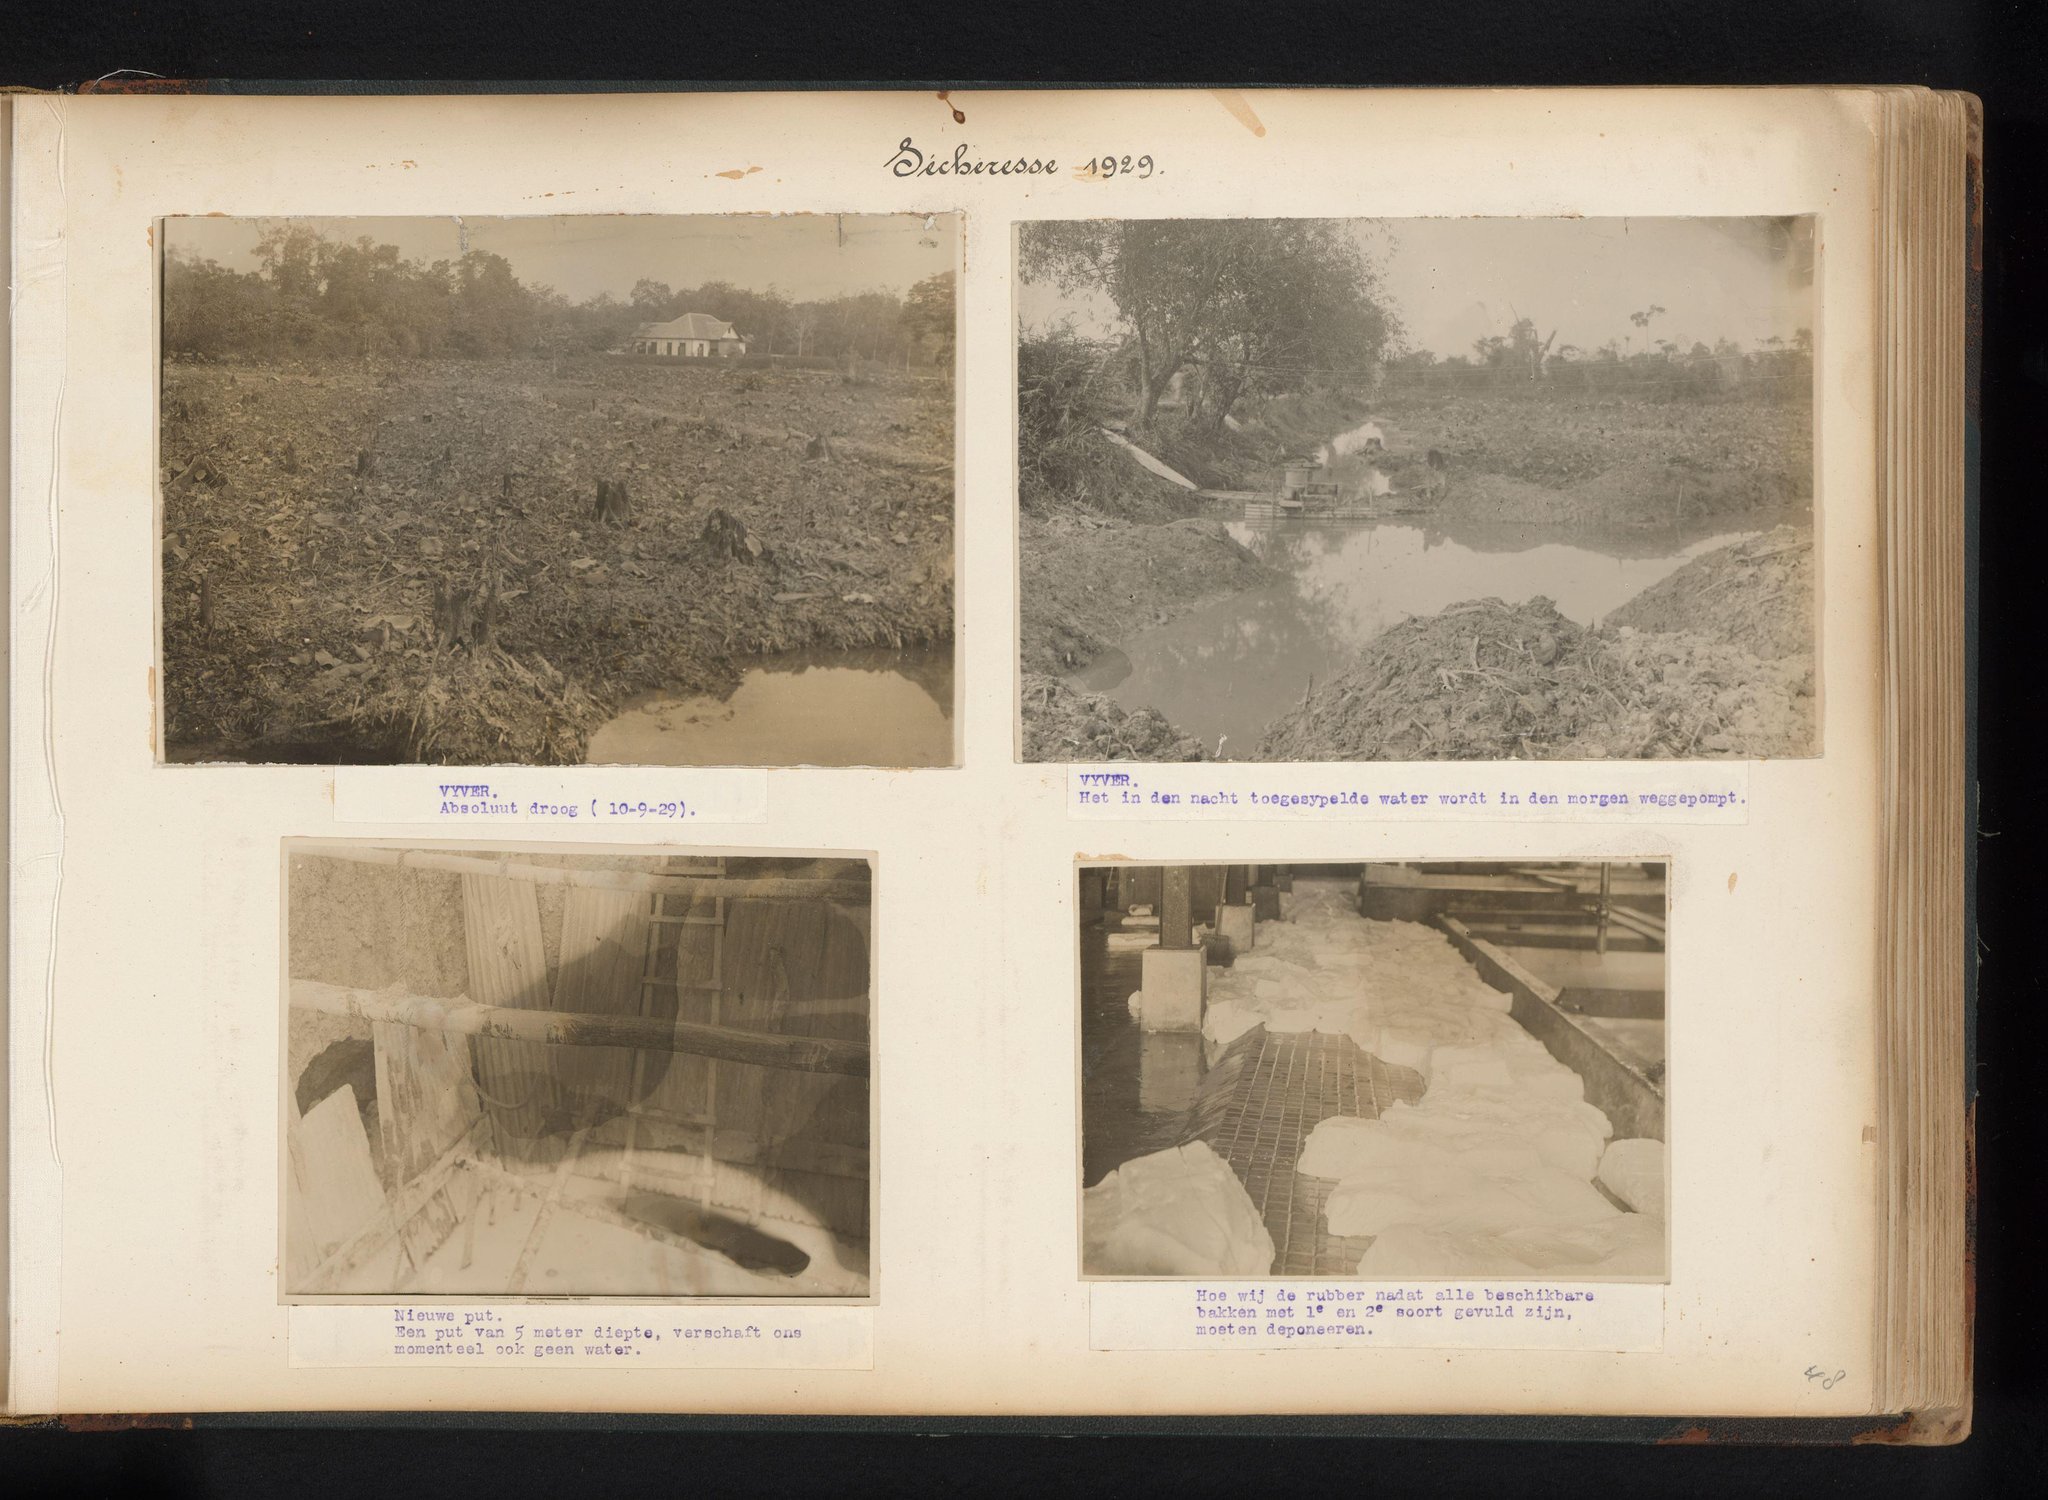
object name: album leaf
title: Sécheresse 1929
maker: Anonymous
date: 1929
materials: cardboard, photographic support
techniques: gelatin silver print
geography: sumatra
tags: plantation, (non-fruit) products of plants or trees: rubber, drought, sumatra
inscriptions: inscription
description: Blad met vier foto's van de droogte van september 1929 op rubberplantage Brussel. Onder de foto's etiketten met onderschriften. Onderdeel van het fotoalbum over de plantages Brussel en Pernantian van de Sumatra Caoutchouc Maatschappij op de Oostkust van Sumatra in de jaren 1910-1935.